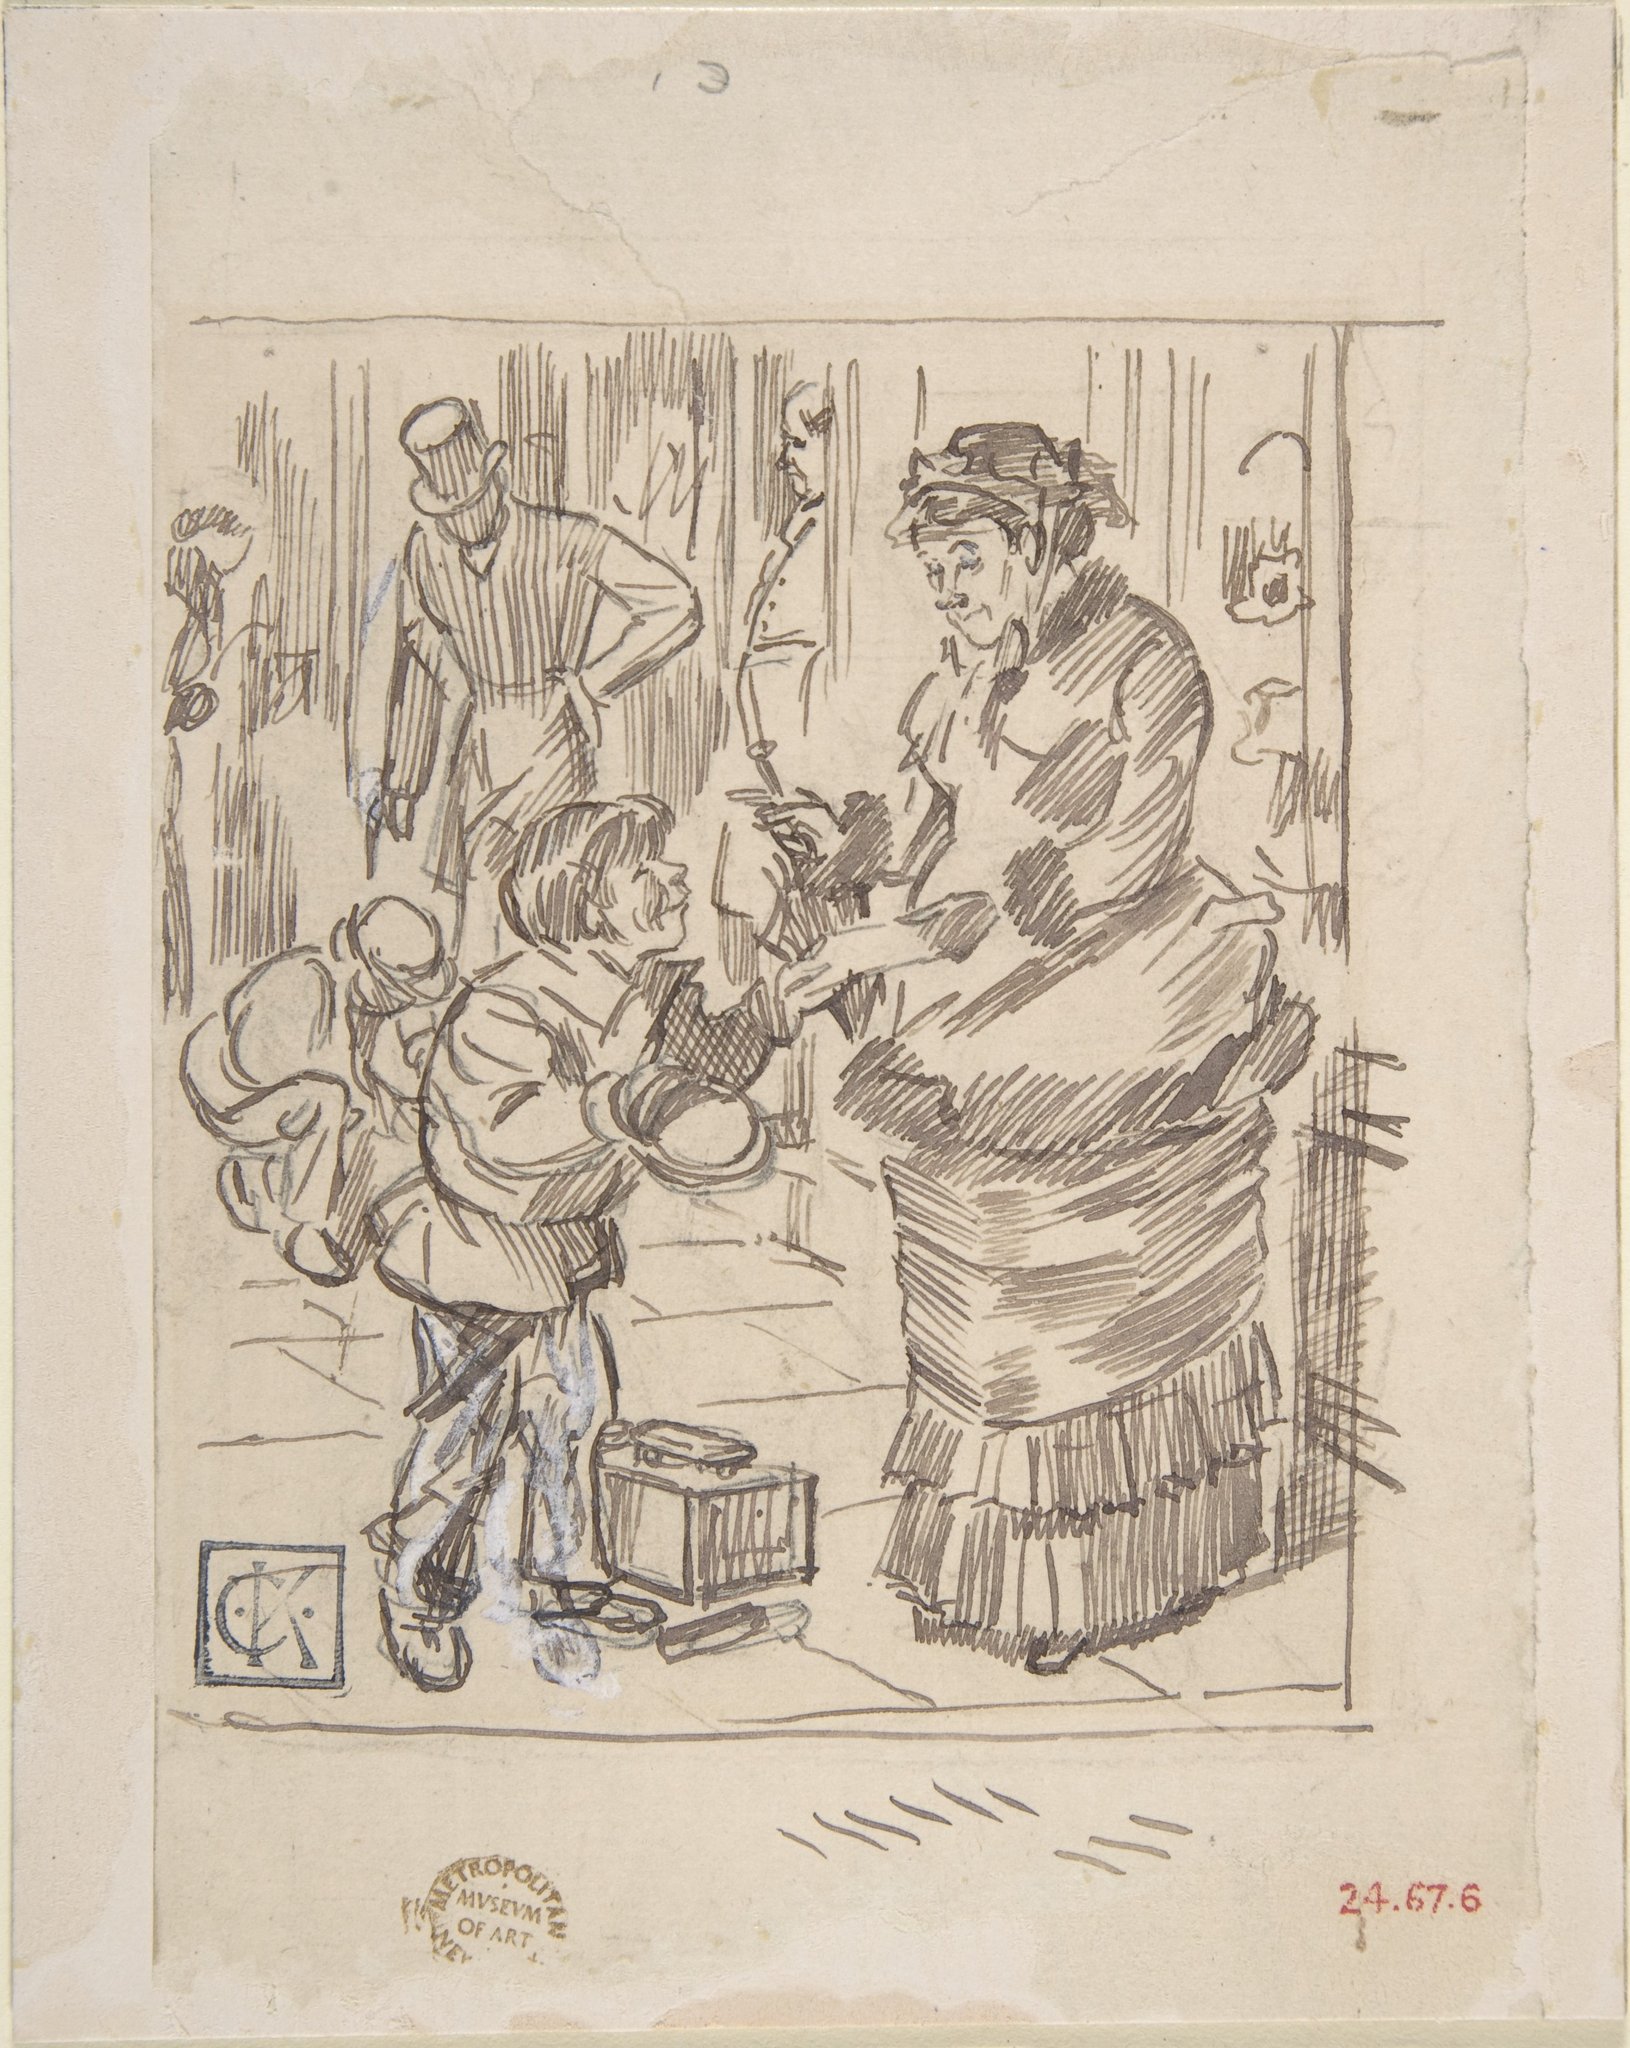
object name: drawing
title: "Tract Distributor"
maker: charles samuel keene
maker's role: artist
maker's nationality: british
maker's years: 1823-1891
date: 1870-1891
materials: gouache, ink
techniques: brush, pen, wash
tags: boys,men,women